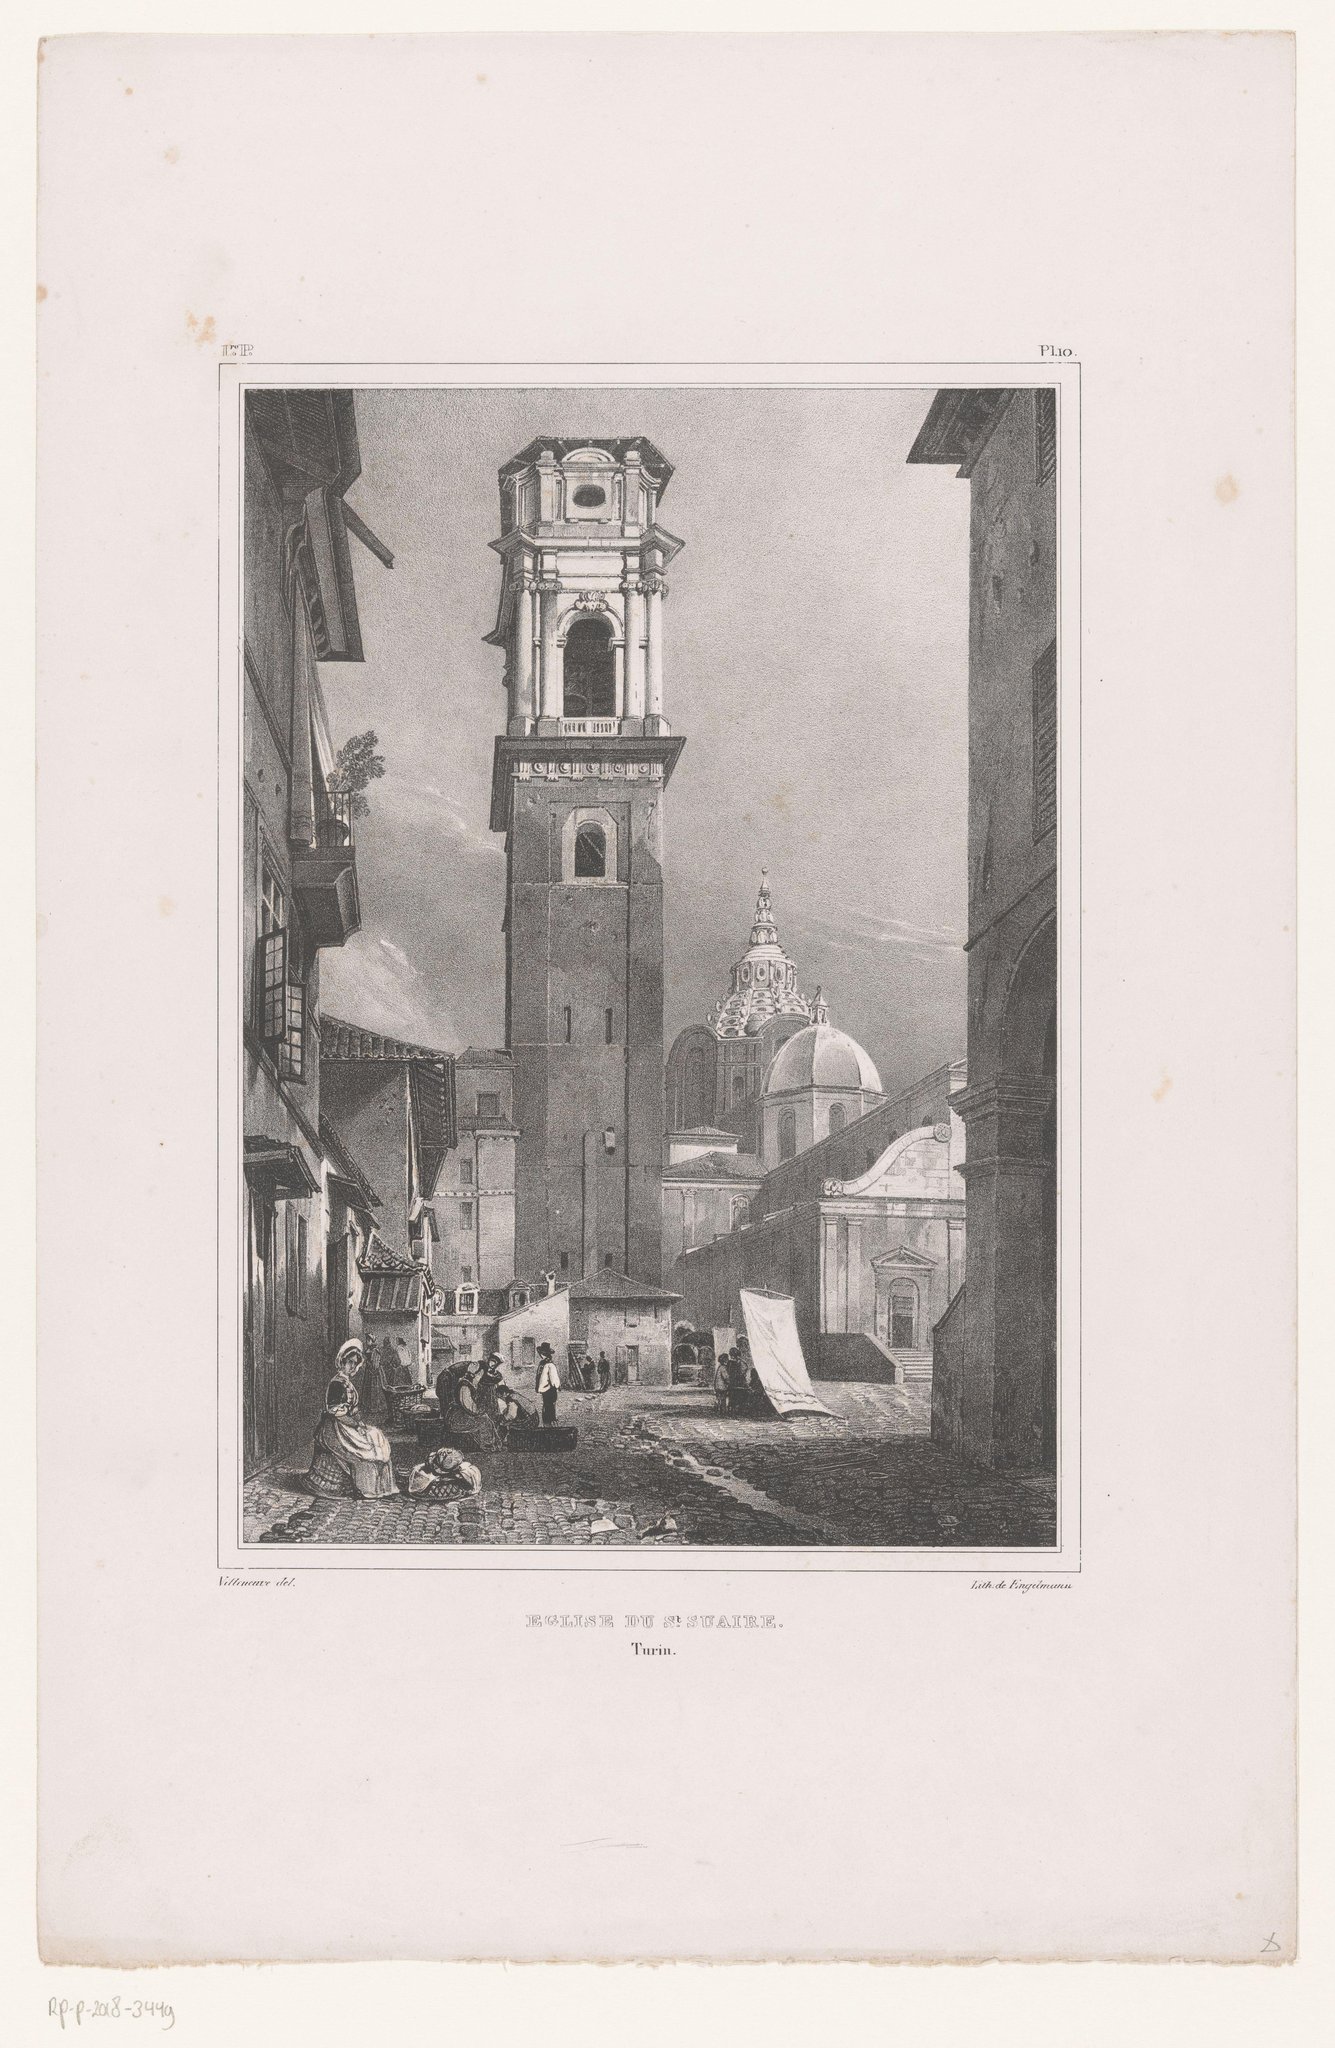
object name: print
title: Gezicht op de Cappella della Sacra Sindone te Turijn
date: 1829-1839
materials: paper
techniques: lithograph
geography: paris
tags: city-view, and landscape with man-made constructions, roman catholic church, parts of church exterior and annexes: tower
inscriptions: collector's mark: Lugt 2228